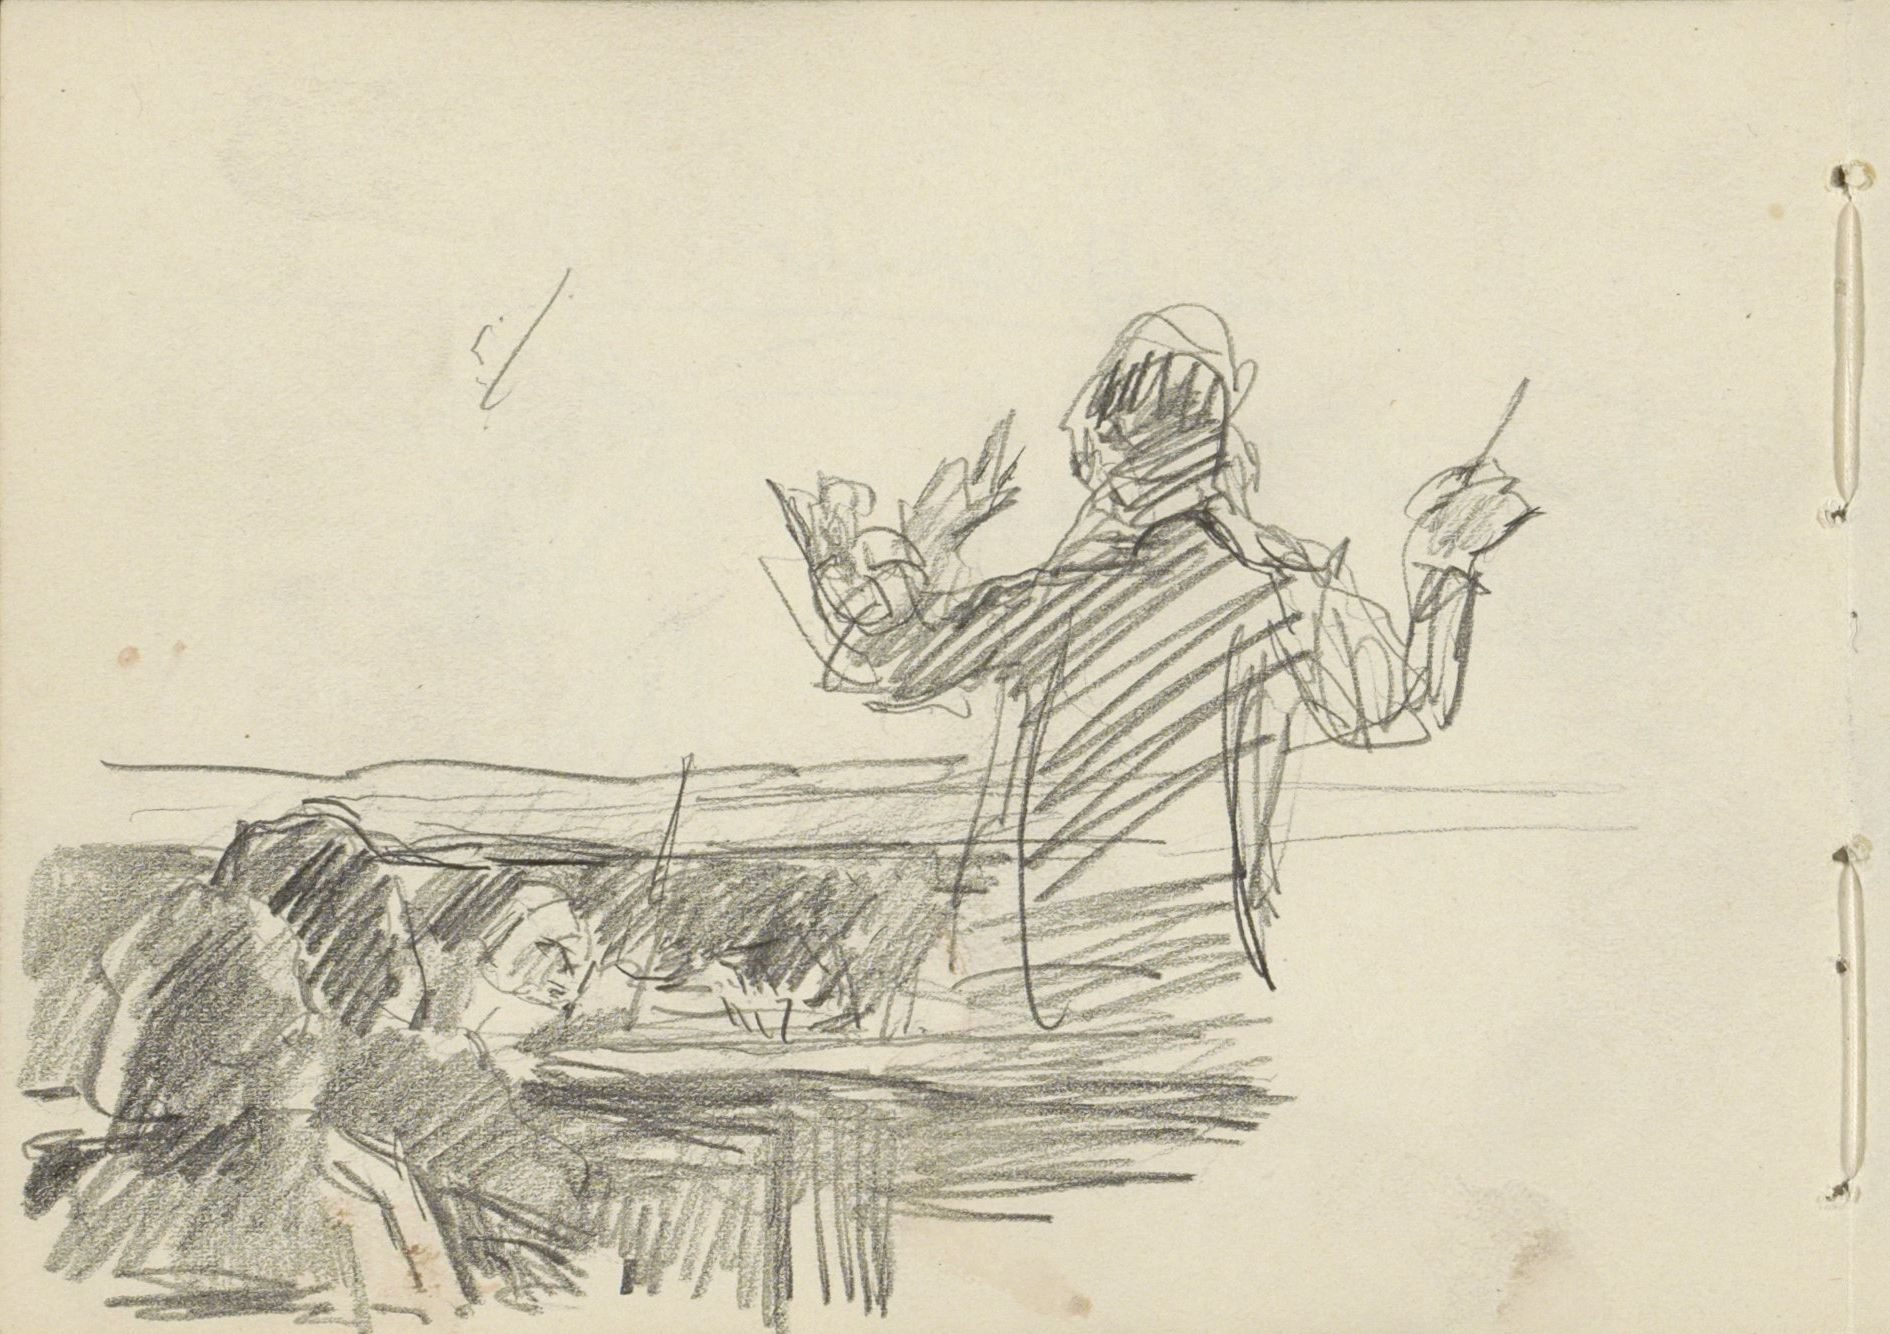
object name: sketchbook leaf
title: Dirigent in een orkestbak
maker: isaac israels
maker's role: draughtsman, painter, print maker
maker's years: 1865-1934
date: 1930-1934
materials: paper, pencil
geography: the hague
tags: large group of musicians, orchestra, the audience ~ art performance, conductor ~ music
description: Vooraan toeschouwers. Pagina 41 uit schetsboek XXXVIII met 45 pagina's.